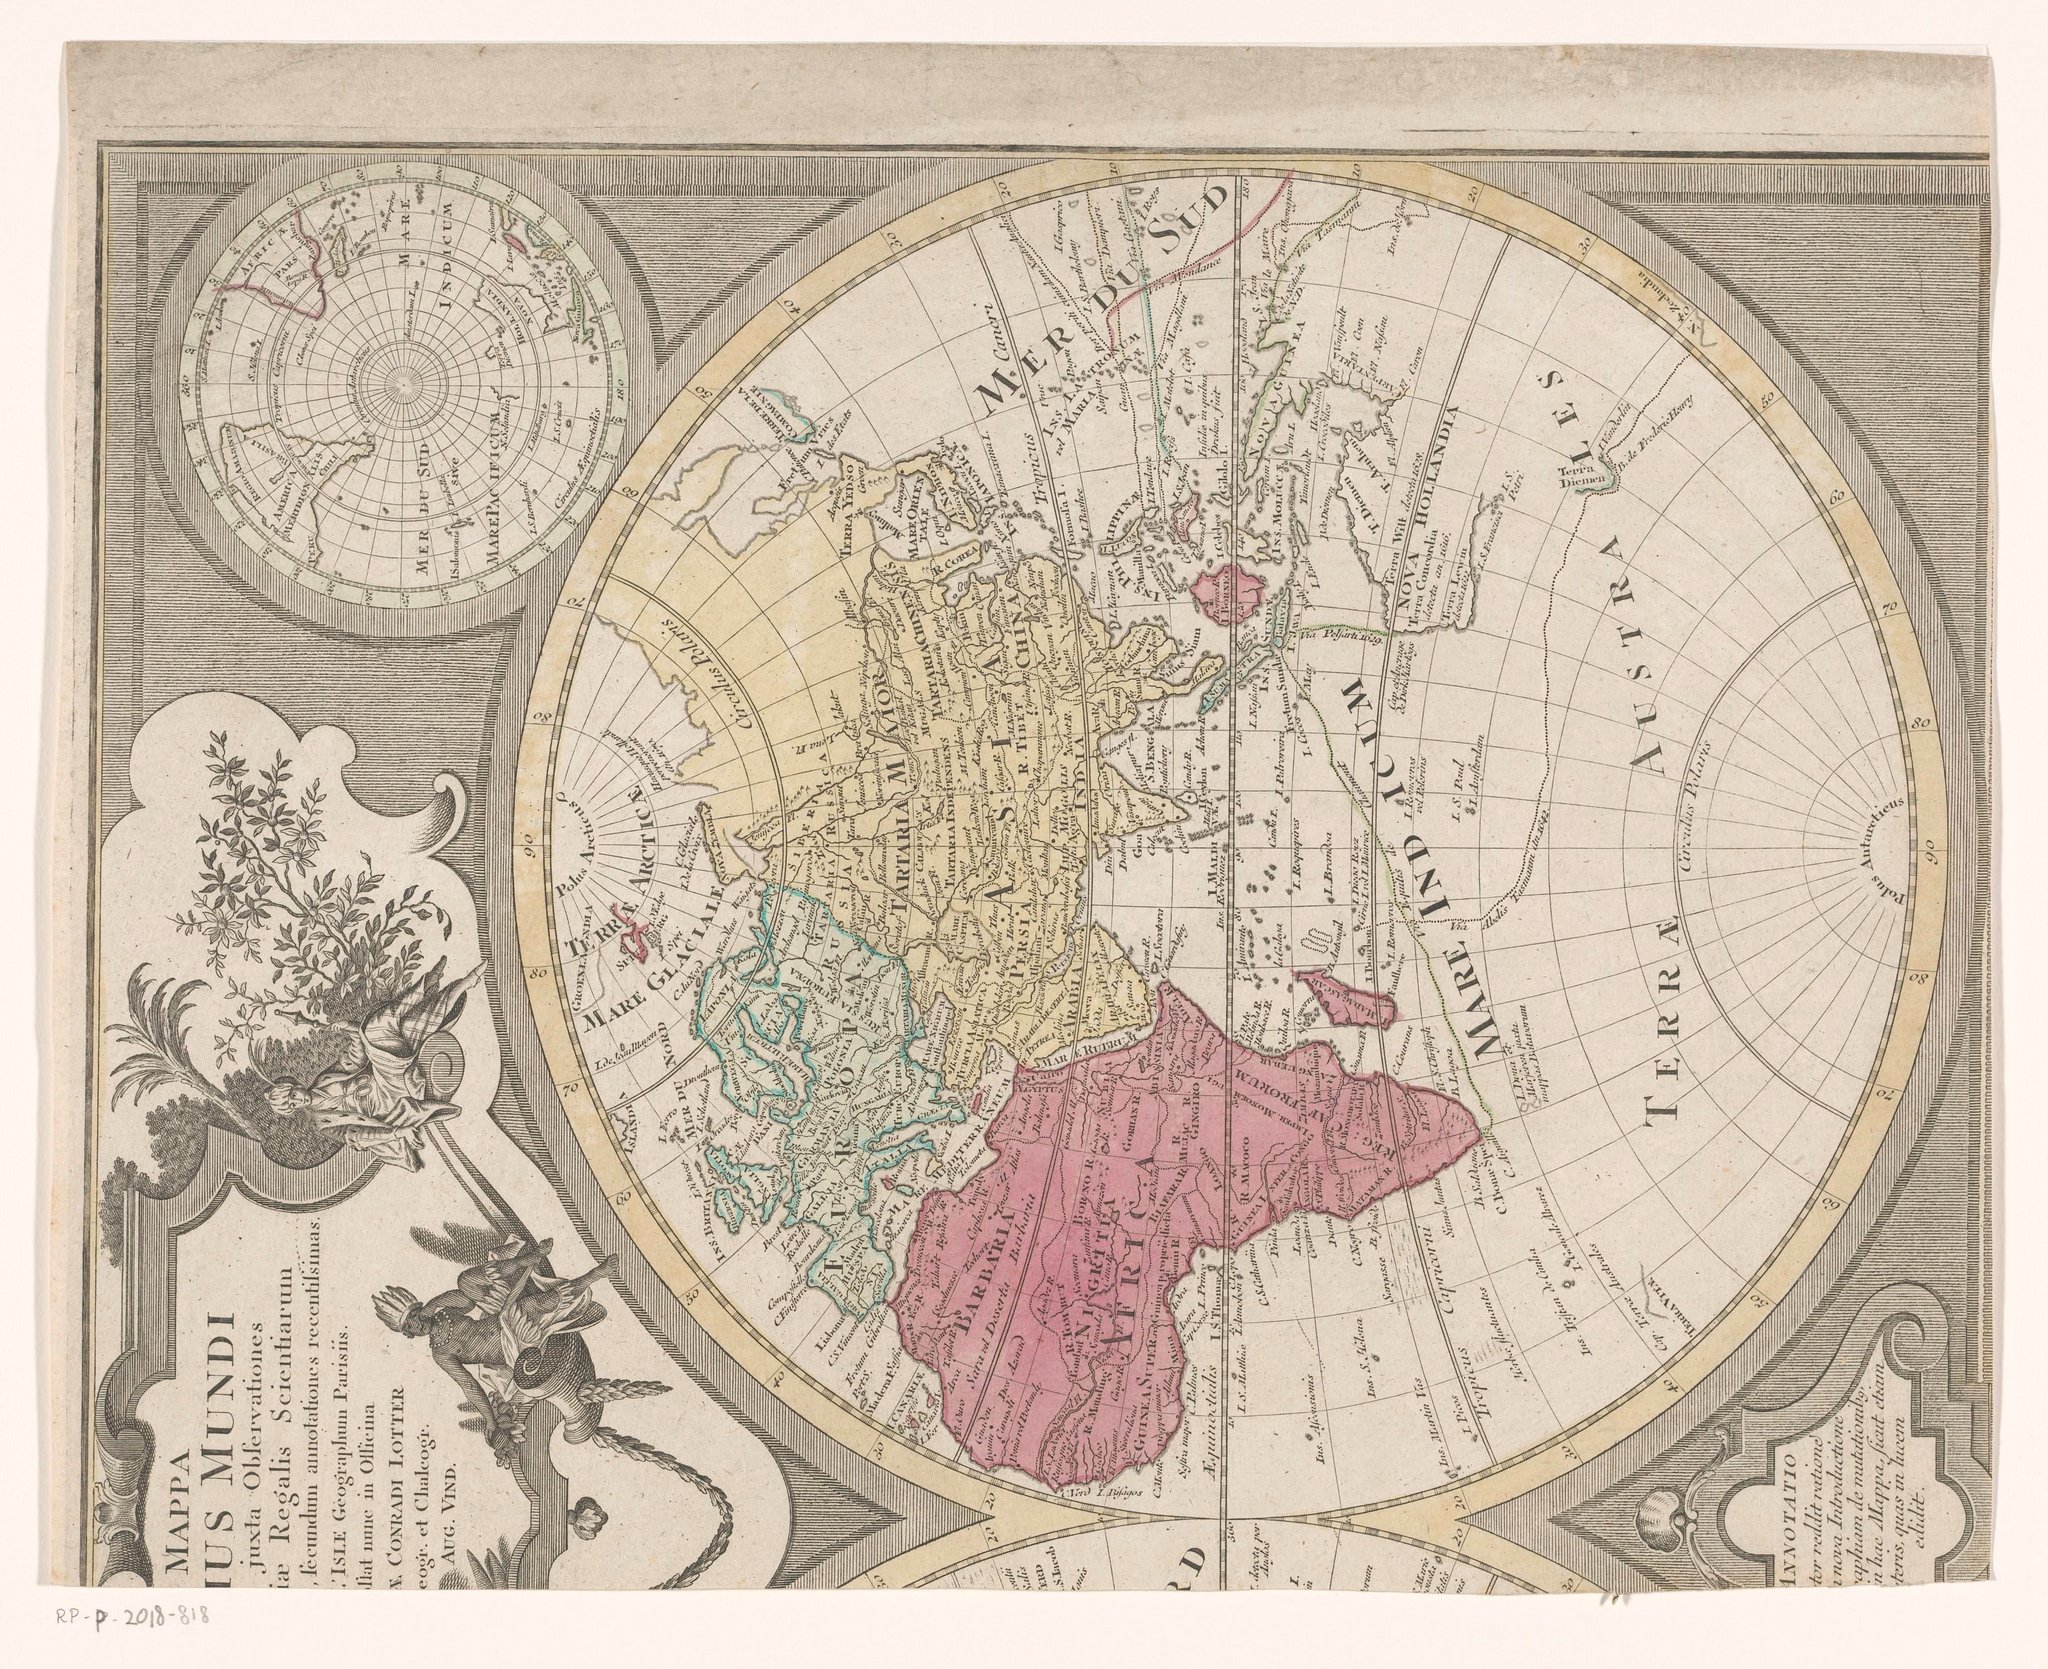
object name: map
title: Rechterhelft van een wereldkaart, met het oostelijk halfrond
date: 1775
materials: paper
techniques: engraving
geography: augsburg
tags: (map of) the polar regions, frigid zones, map of the world, exploration, expedition, voyage of discovery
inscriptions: collector's mark: Lugt 2228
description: Rechterhelft van een wereldkaart, nu is slechts het oostelijk halfrond te zien. Linksboven de titelcartouche, met een allegorische weergave van twee van de vier grote continenten in de vorm van vrouwfiguren. Op de kaart zijn Nova Hollandia en de reis van Abel Tasman van 1642 te zien. Rechtsboven een kaart van de zuidpool. De kaart is voorzien van een gradenverdeling langs de randen.